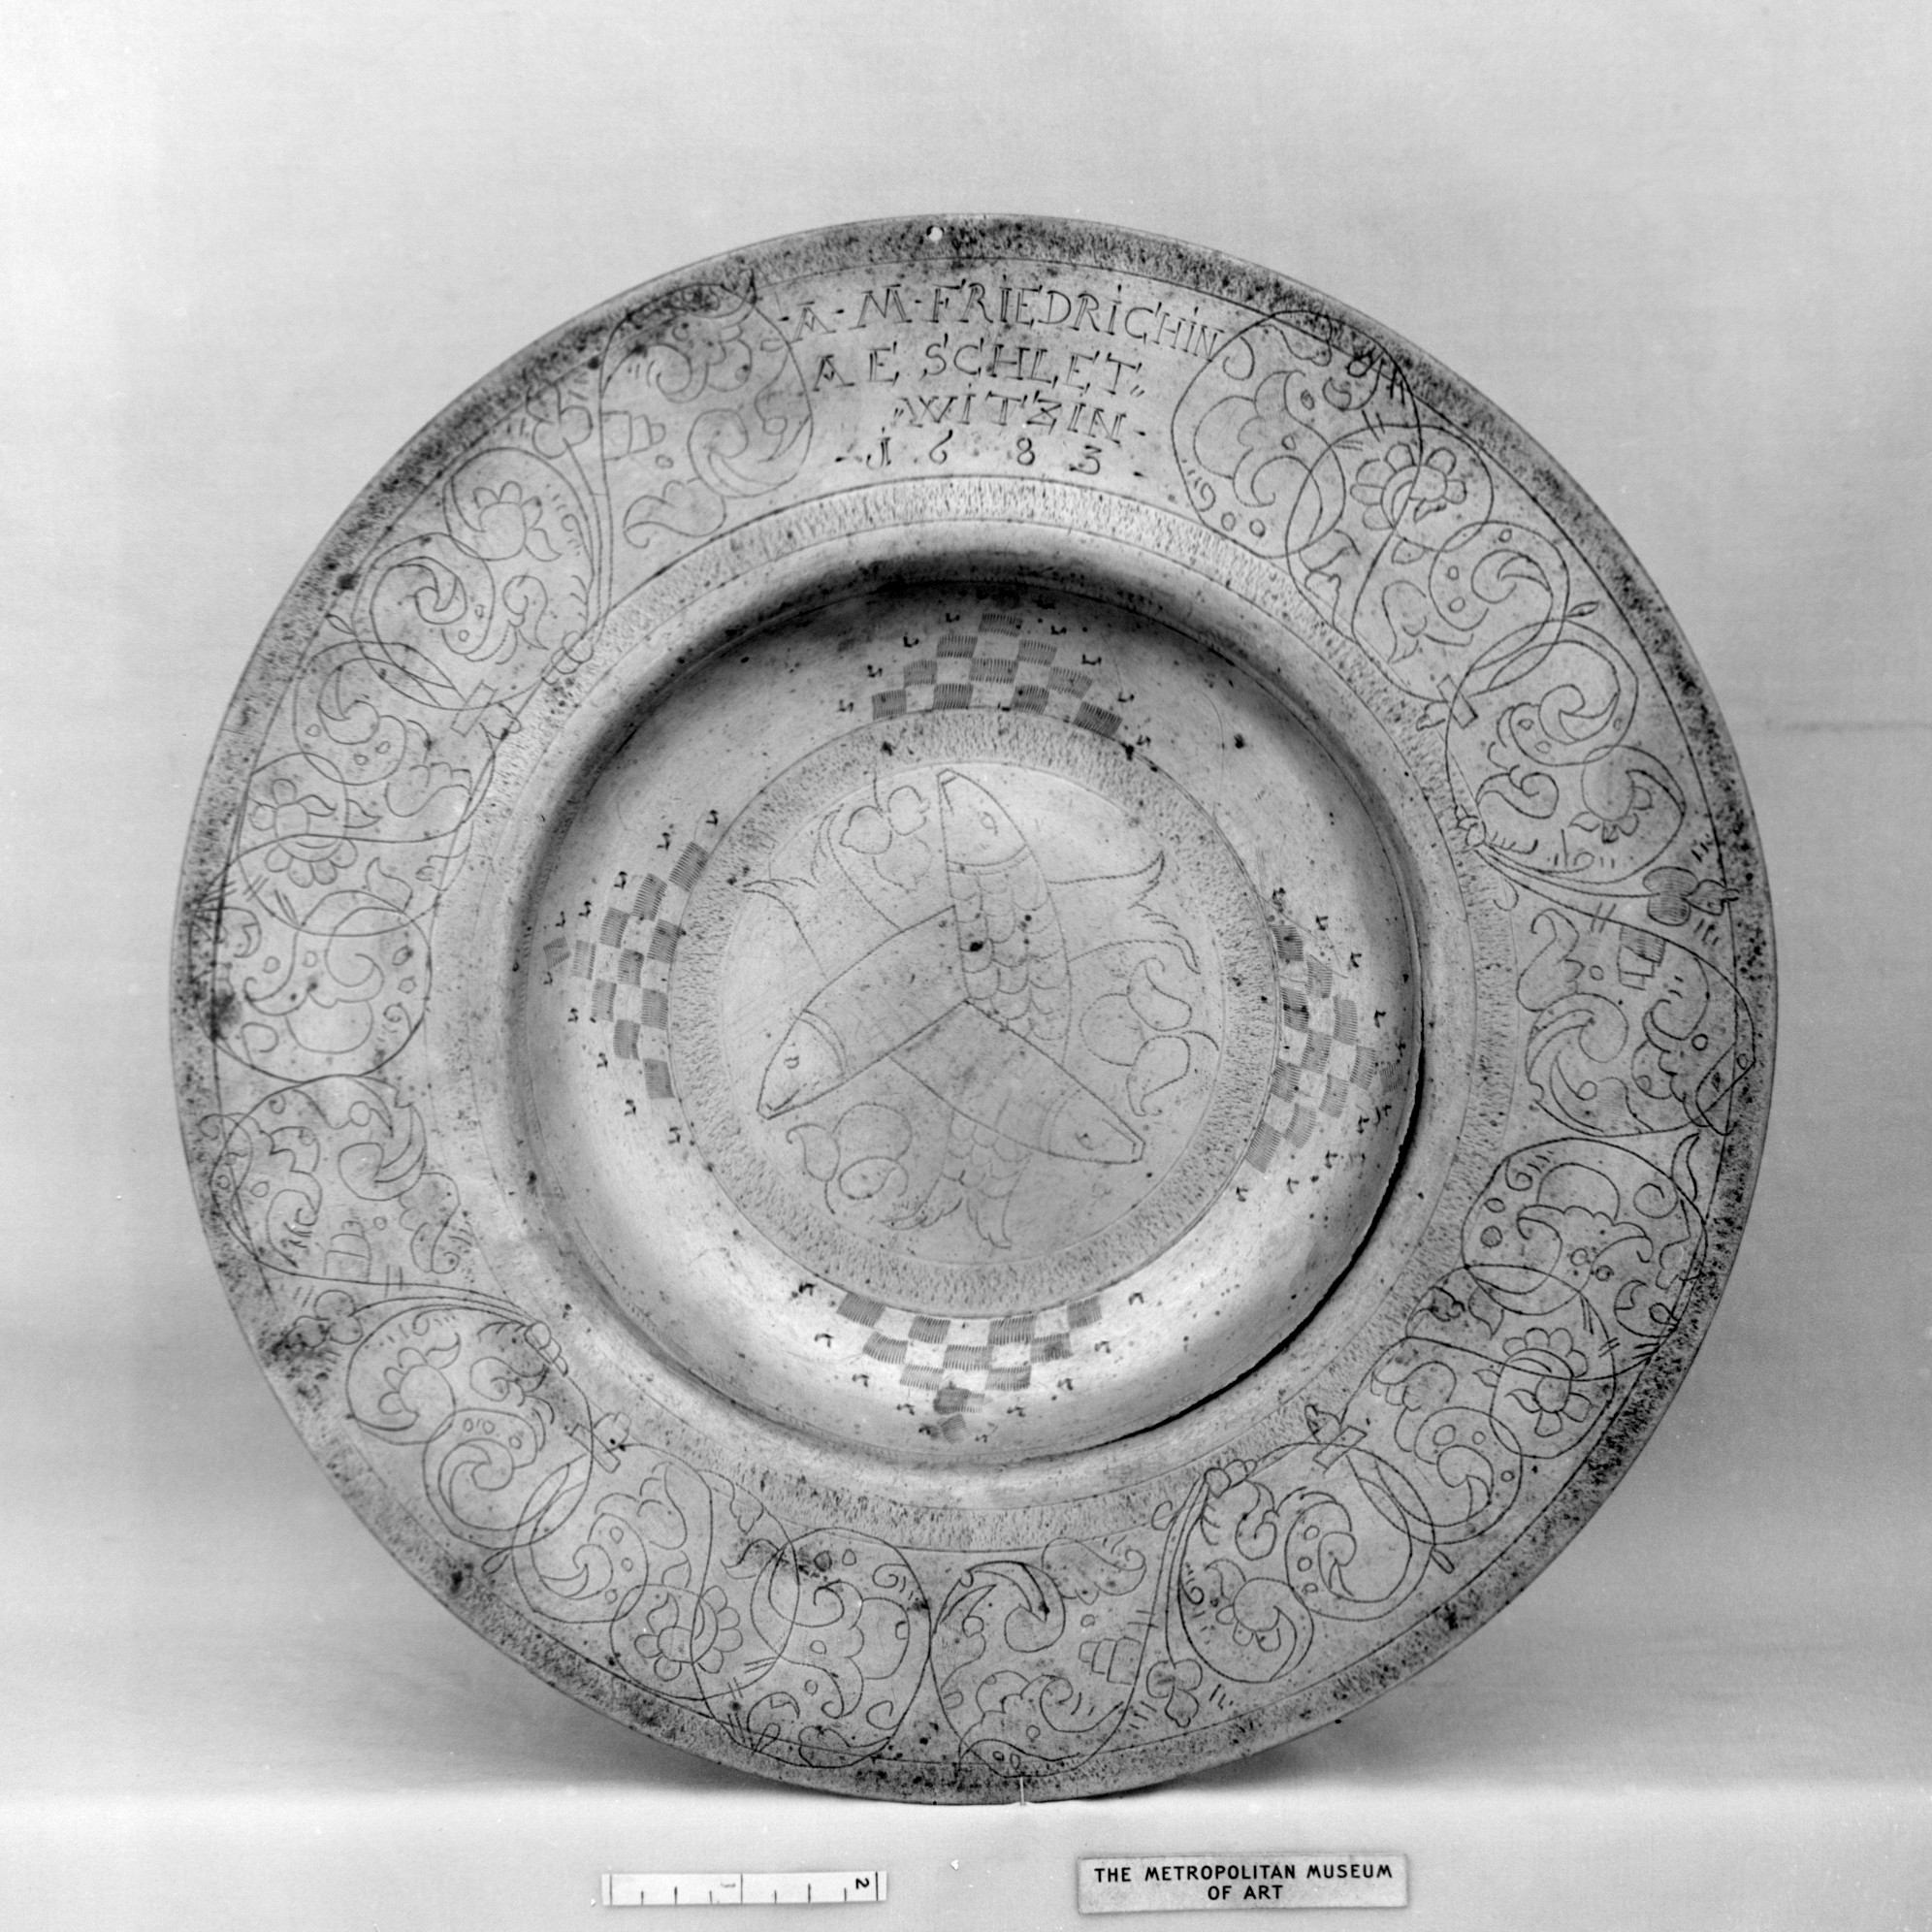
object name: dish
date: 1601-1633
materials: pewter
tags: fish